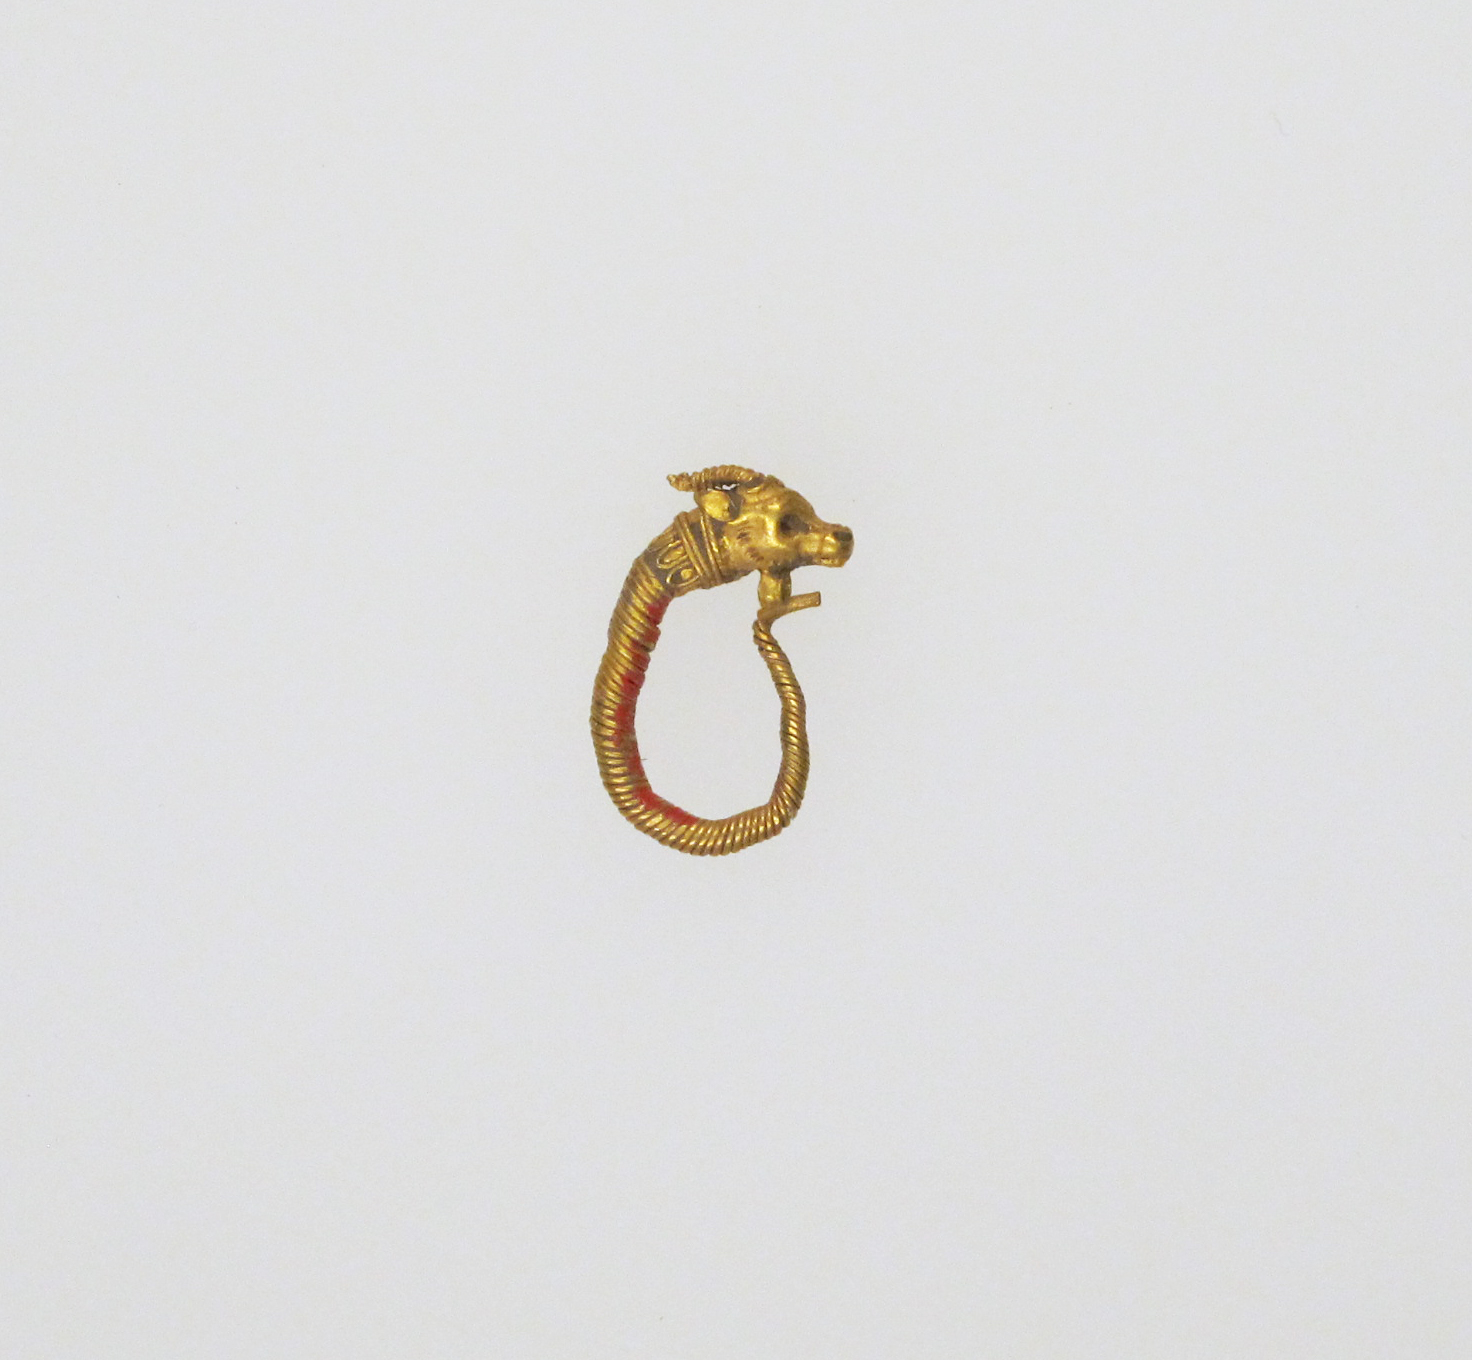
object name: earring with head of goat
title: Earring with head of a goat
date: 7000 BCE-330 CE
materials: gold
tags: goats